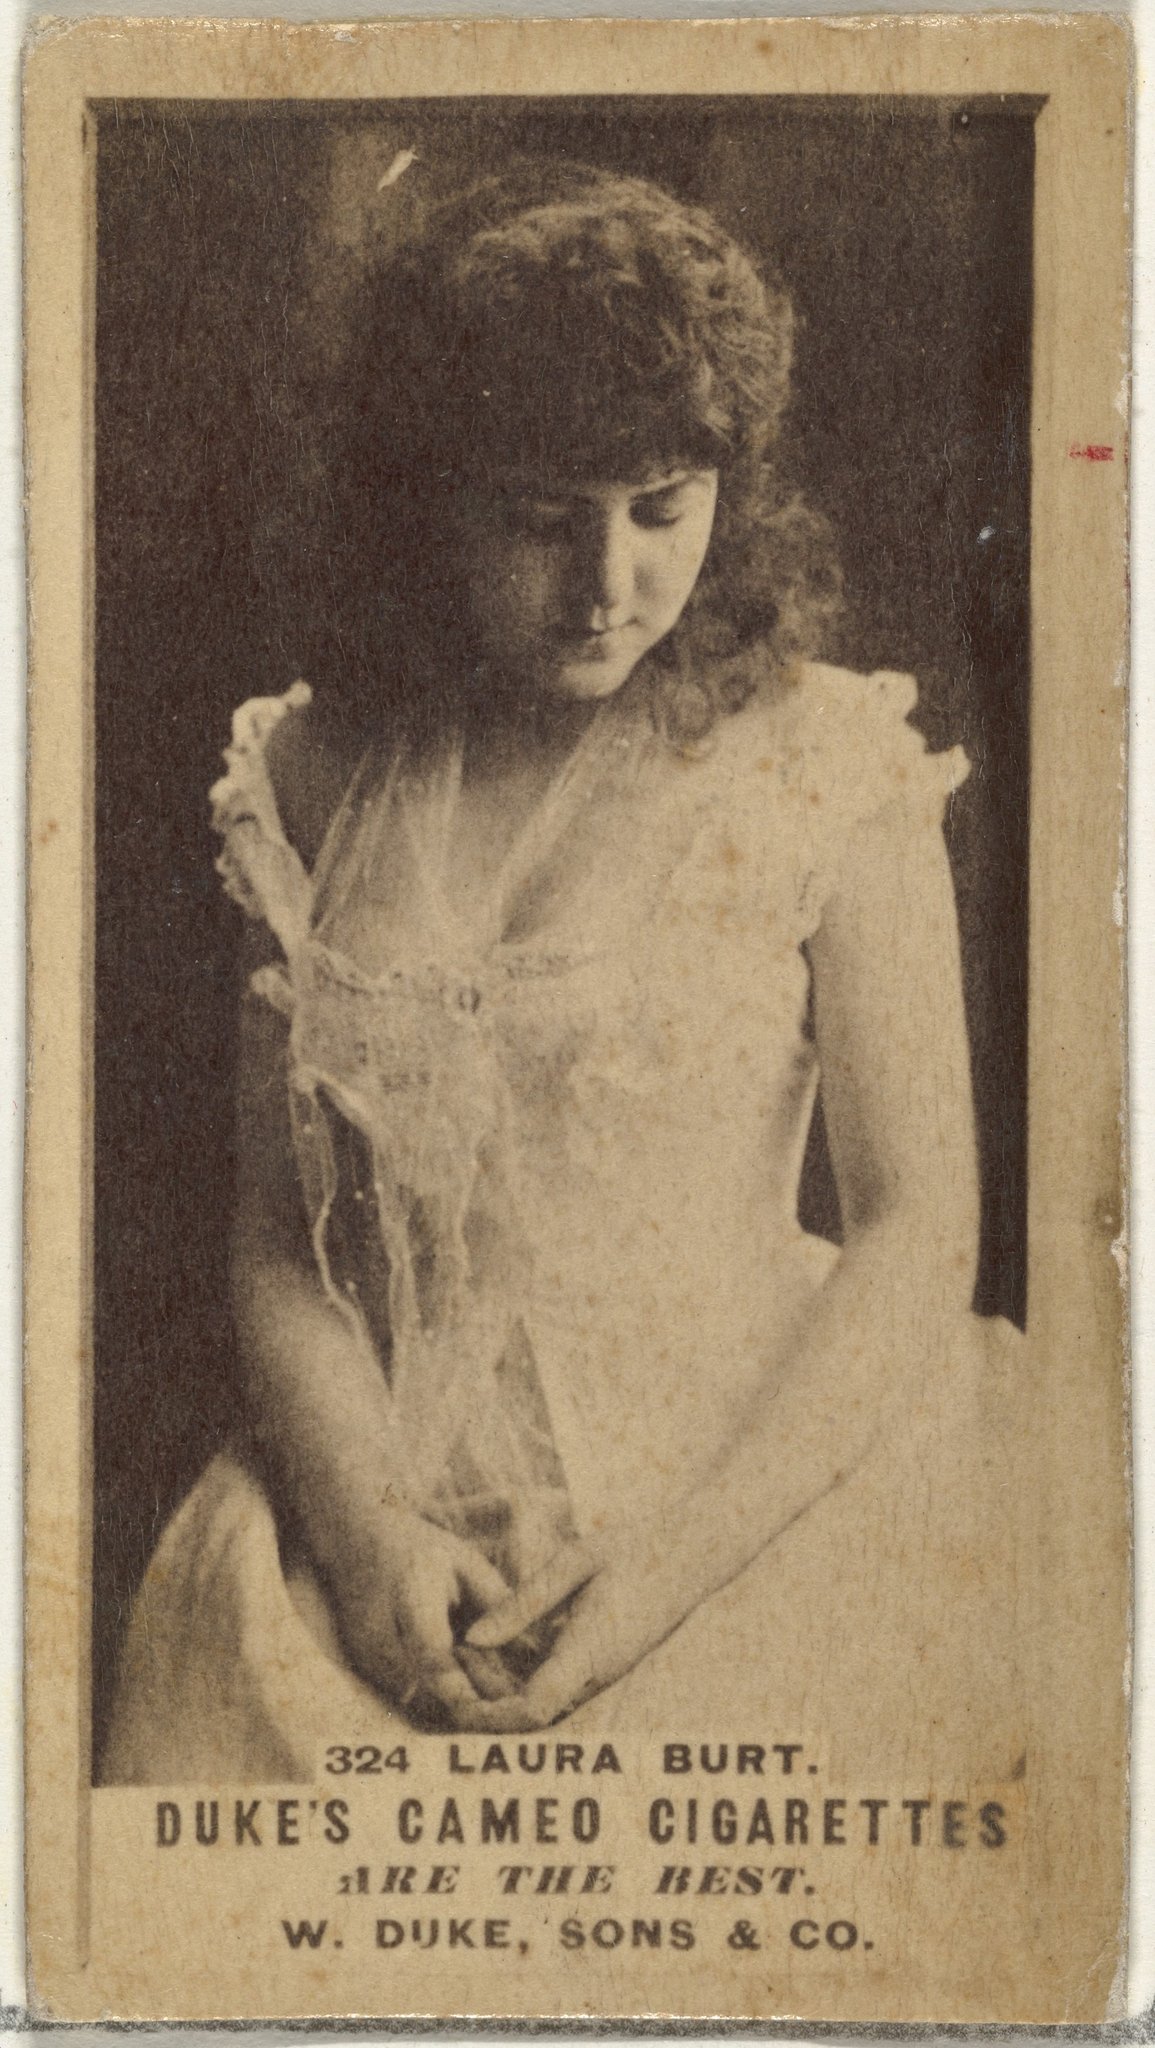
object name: photograph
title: Card Number 324, Laura Burt, from the Actors and Actresses series (N145-5) issued by Duke Sons & Co. to promote Cameo Cigarettes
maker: w. duke, sons & co.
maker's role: publisher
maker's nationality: american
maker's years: 1870-1920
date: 1880-1889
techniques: albumen silver print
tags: portraits,women,actresses